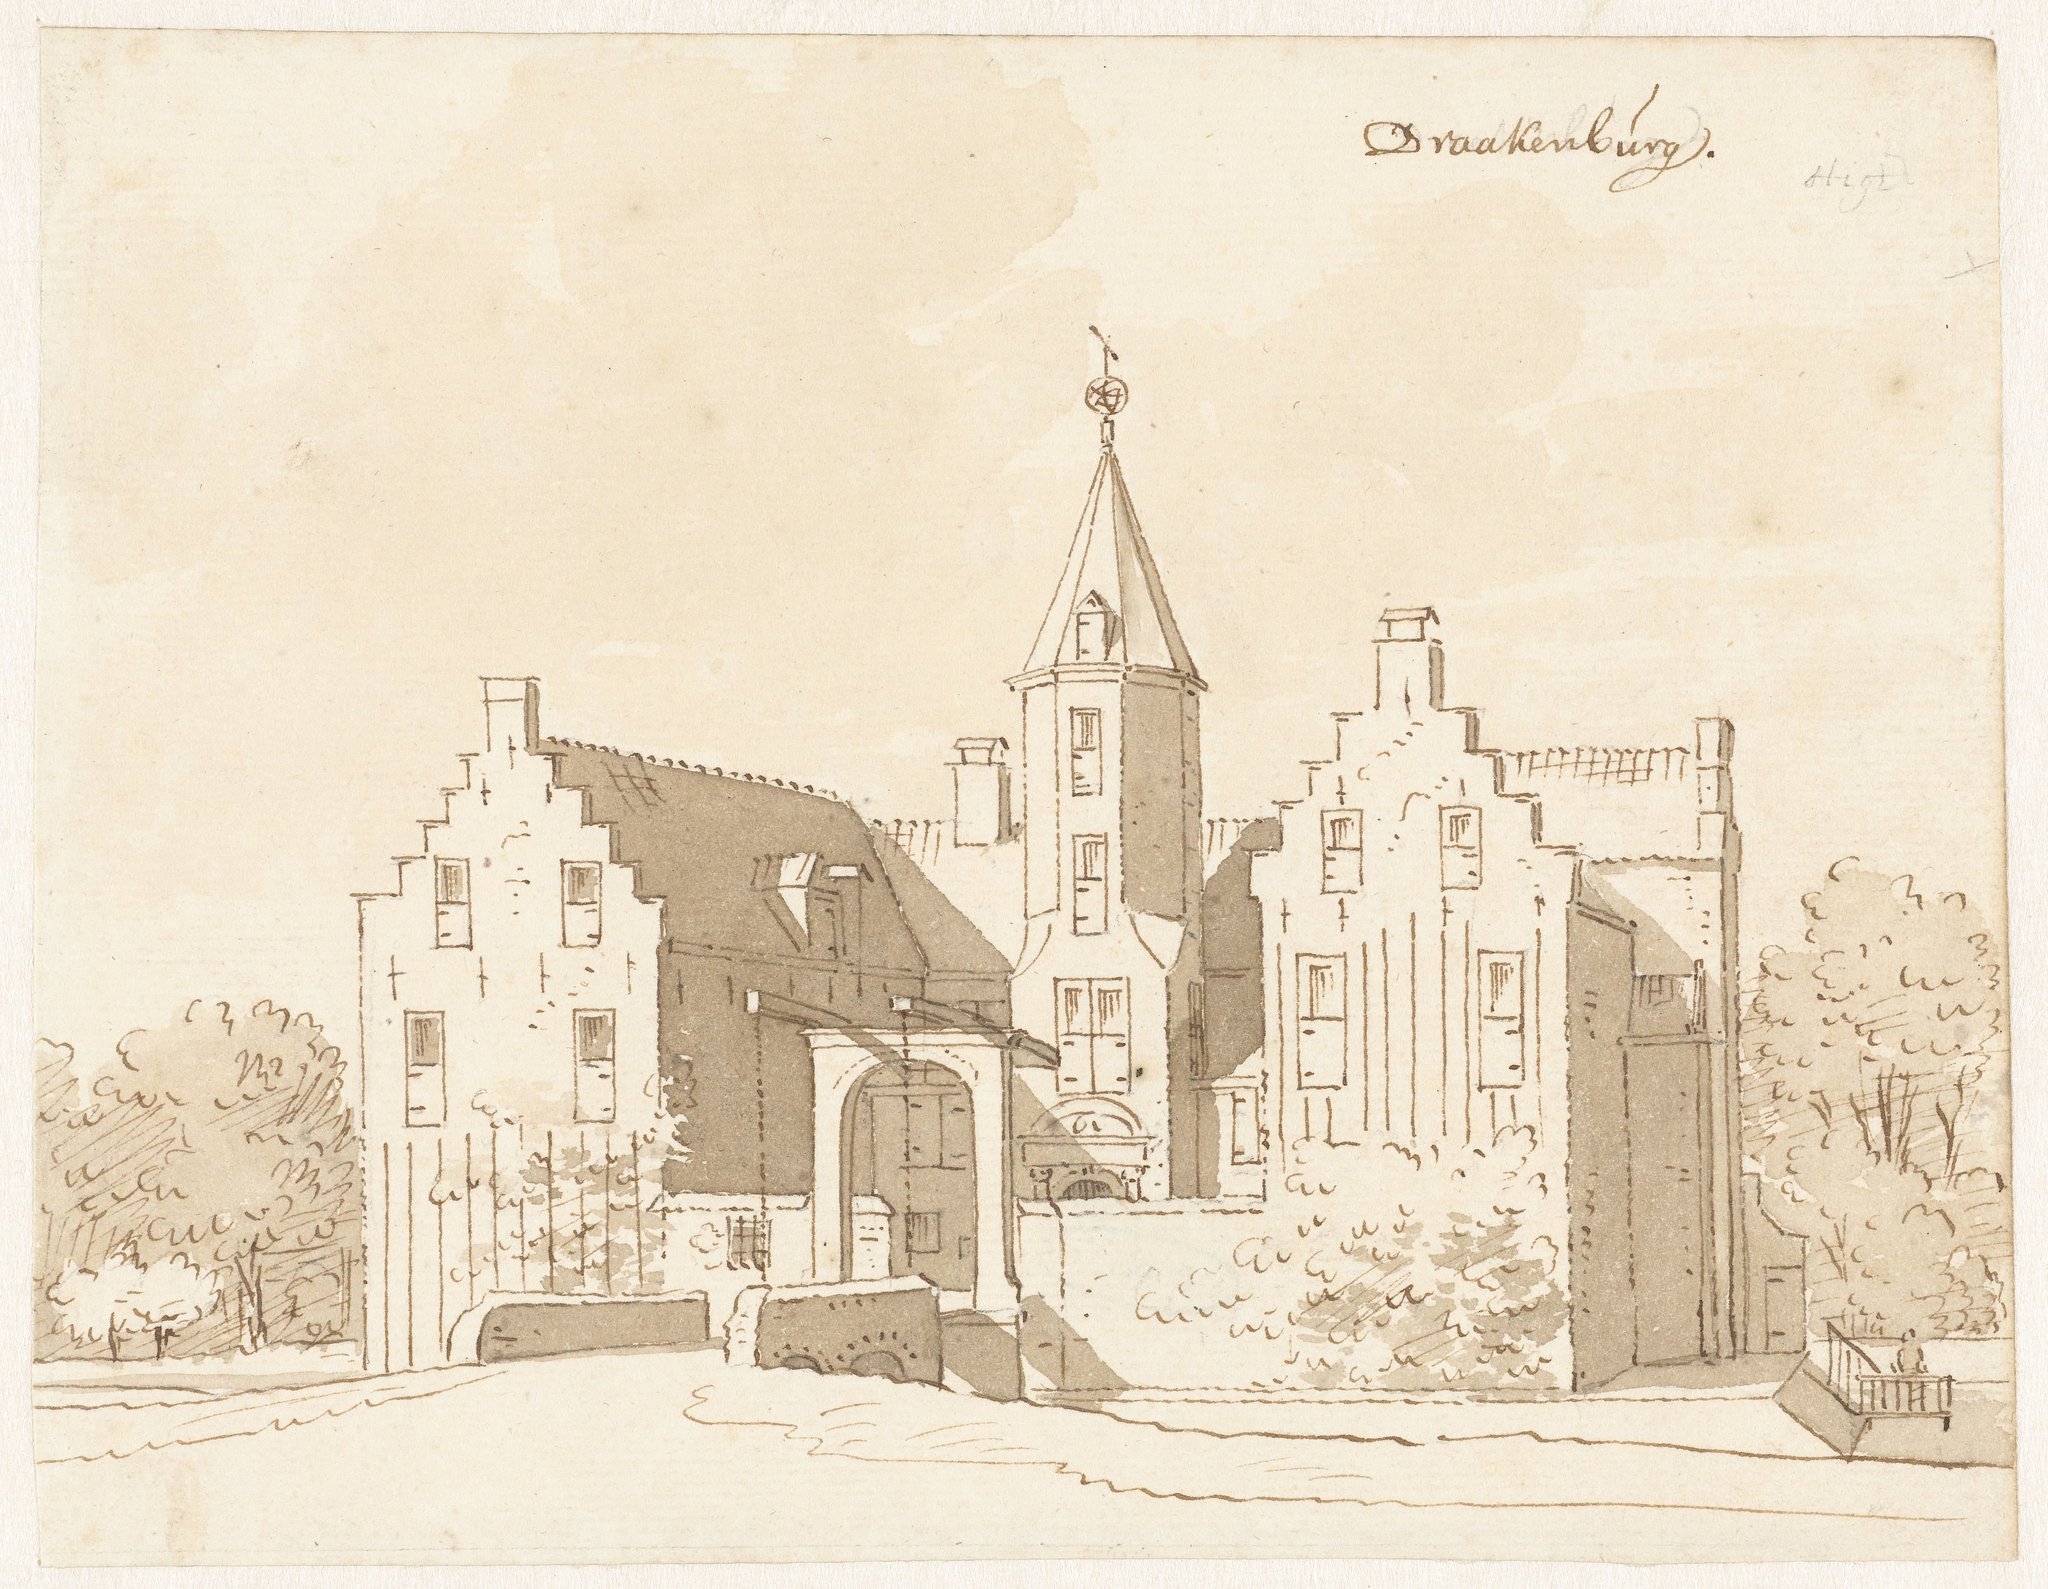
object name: drawing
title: Kasteel Drakenburg bij Baarn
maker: cornelis pronk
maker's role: draughtsman, painter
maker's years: 1691-1759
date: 1701-1759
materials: ink, paper, pencil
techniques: brush, pen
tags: castle